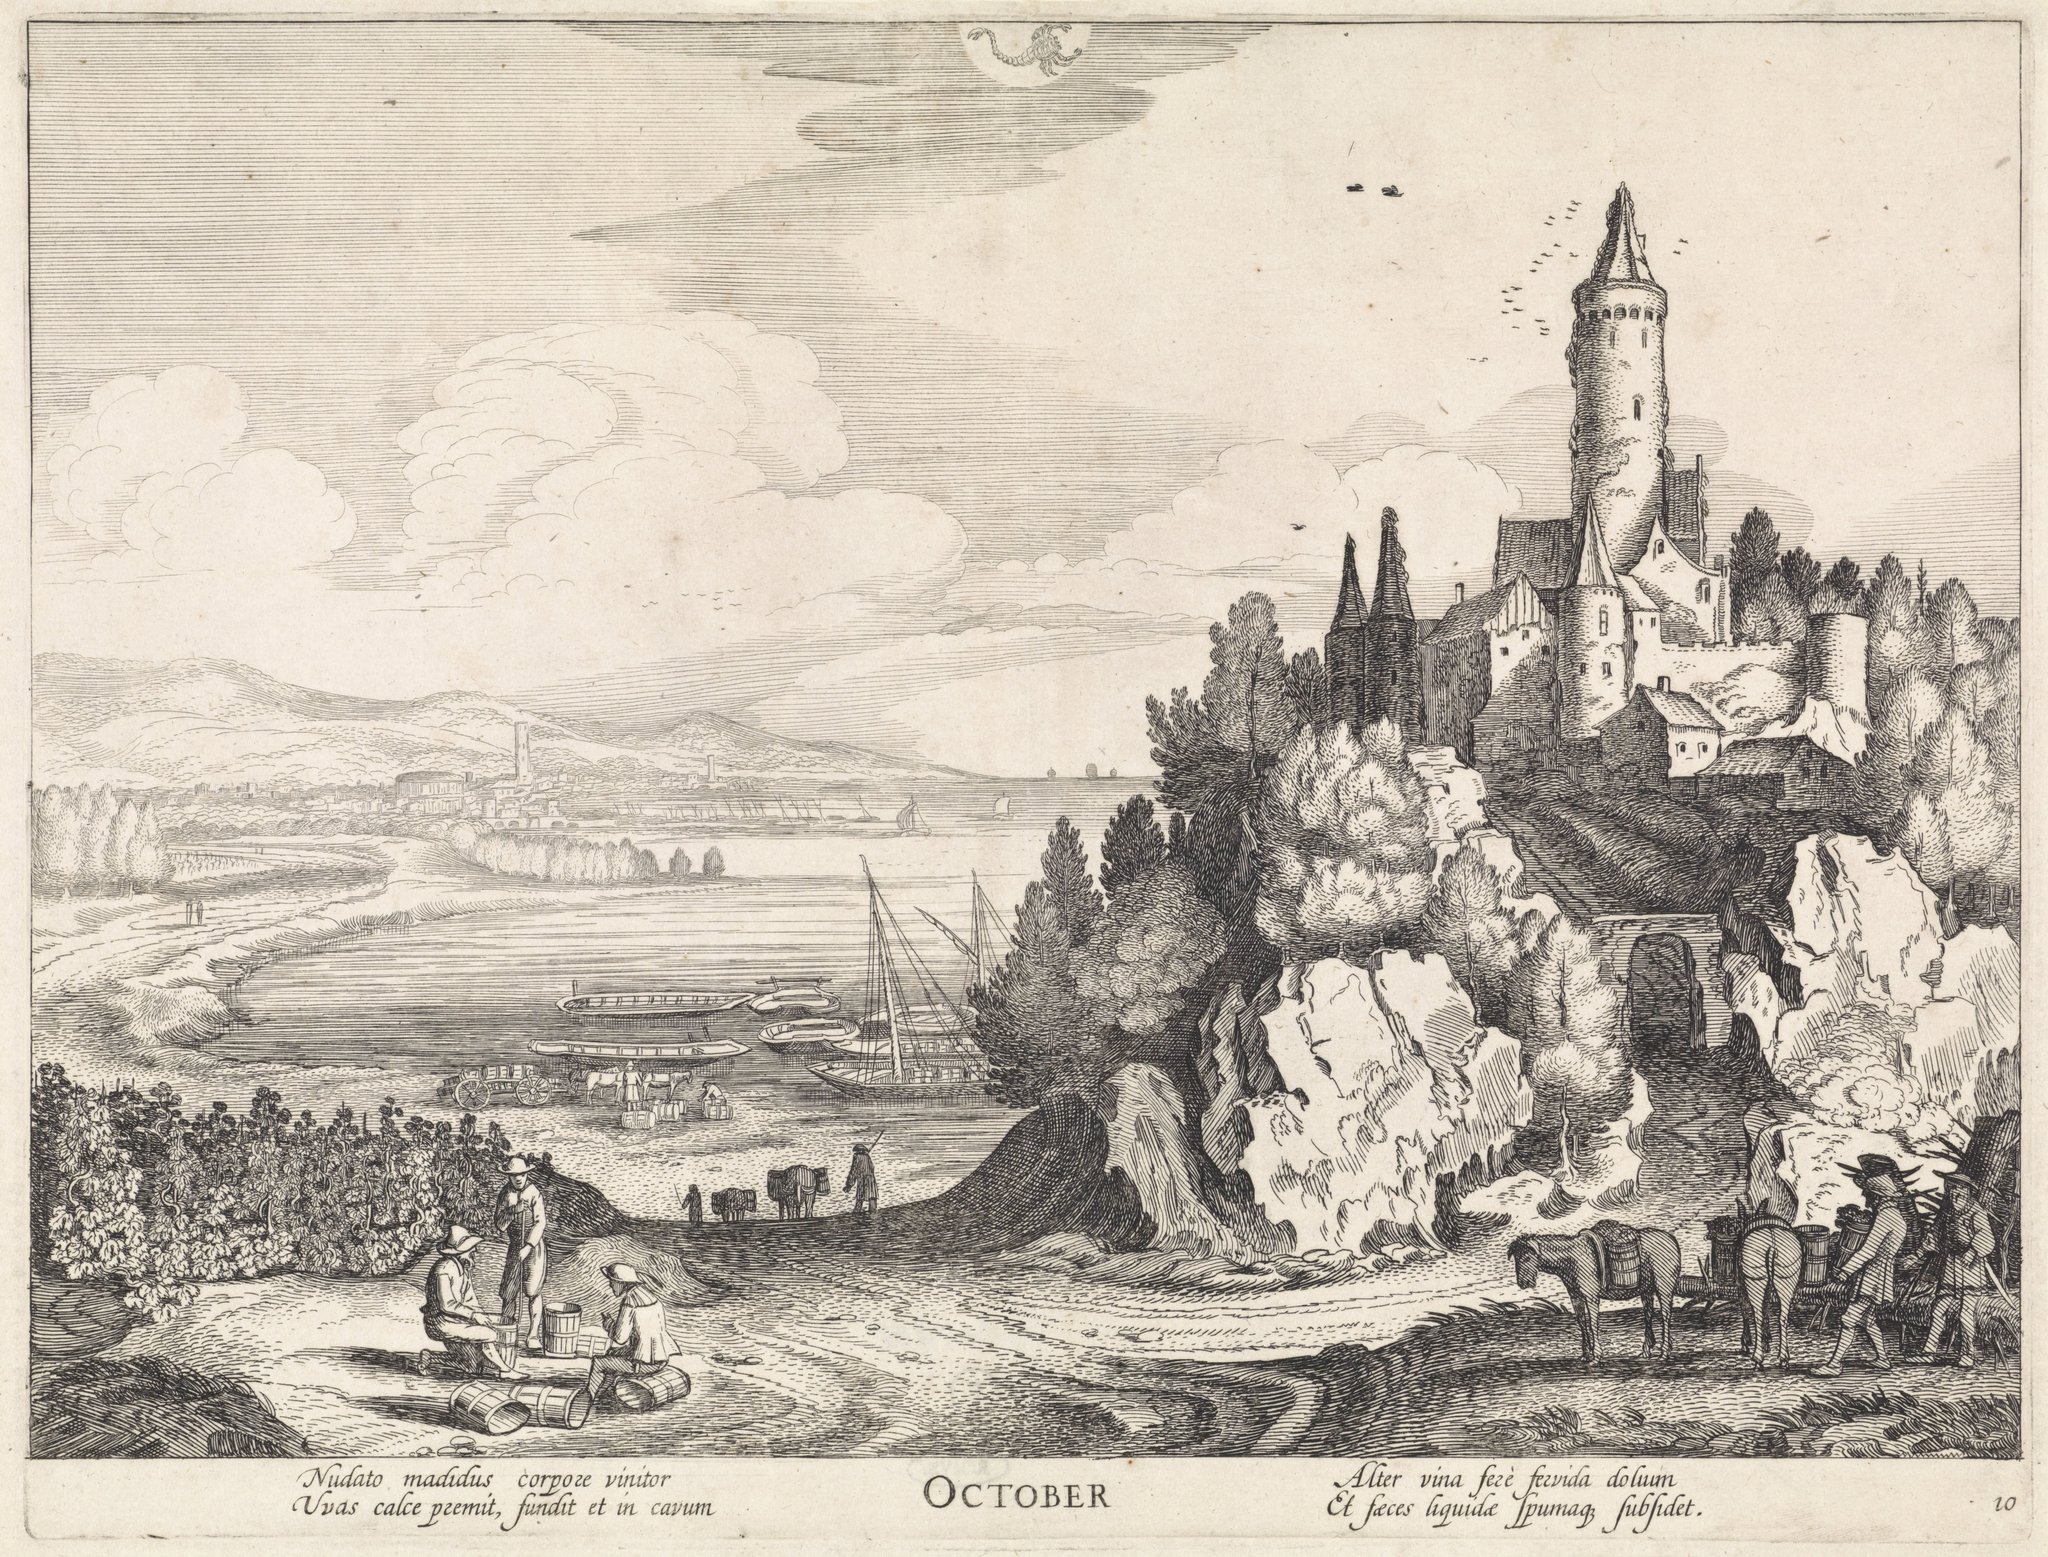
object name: print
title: De twaalf maanden, met dorpsgezichten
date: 1618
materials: paper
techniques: etching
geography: northern netherlands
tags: landscape symbolizing october, vineyard, castle, october and its 'labours', scorpio (zodiacal sign of october), transport of grapes, viticulture, wine-growing; vintage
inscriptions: collector's mark: Lugt 964